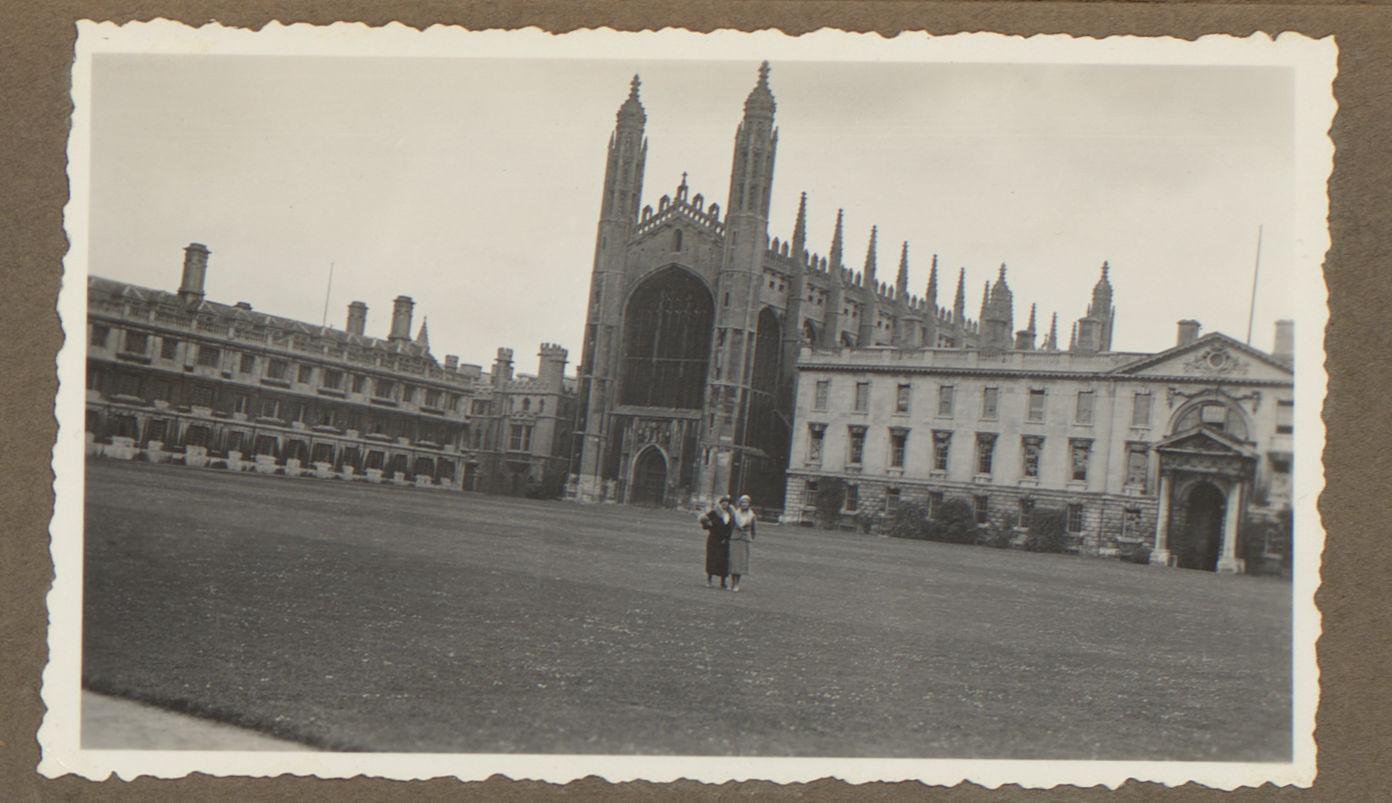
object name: album leaf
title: Henriëtte van Bergen en een vrouw voor King's College, Cambridge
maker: Anonymous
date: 1906-1932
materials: paper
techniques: gelatin silver print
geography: cambridge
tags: surabaya, historical persons - bb - woman, university building, college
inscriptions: inscription: ‘Cambridge’